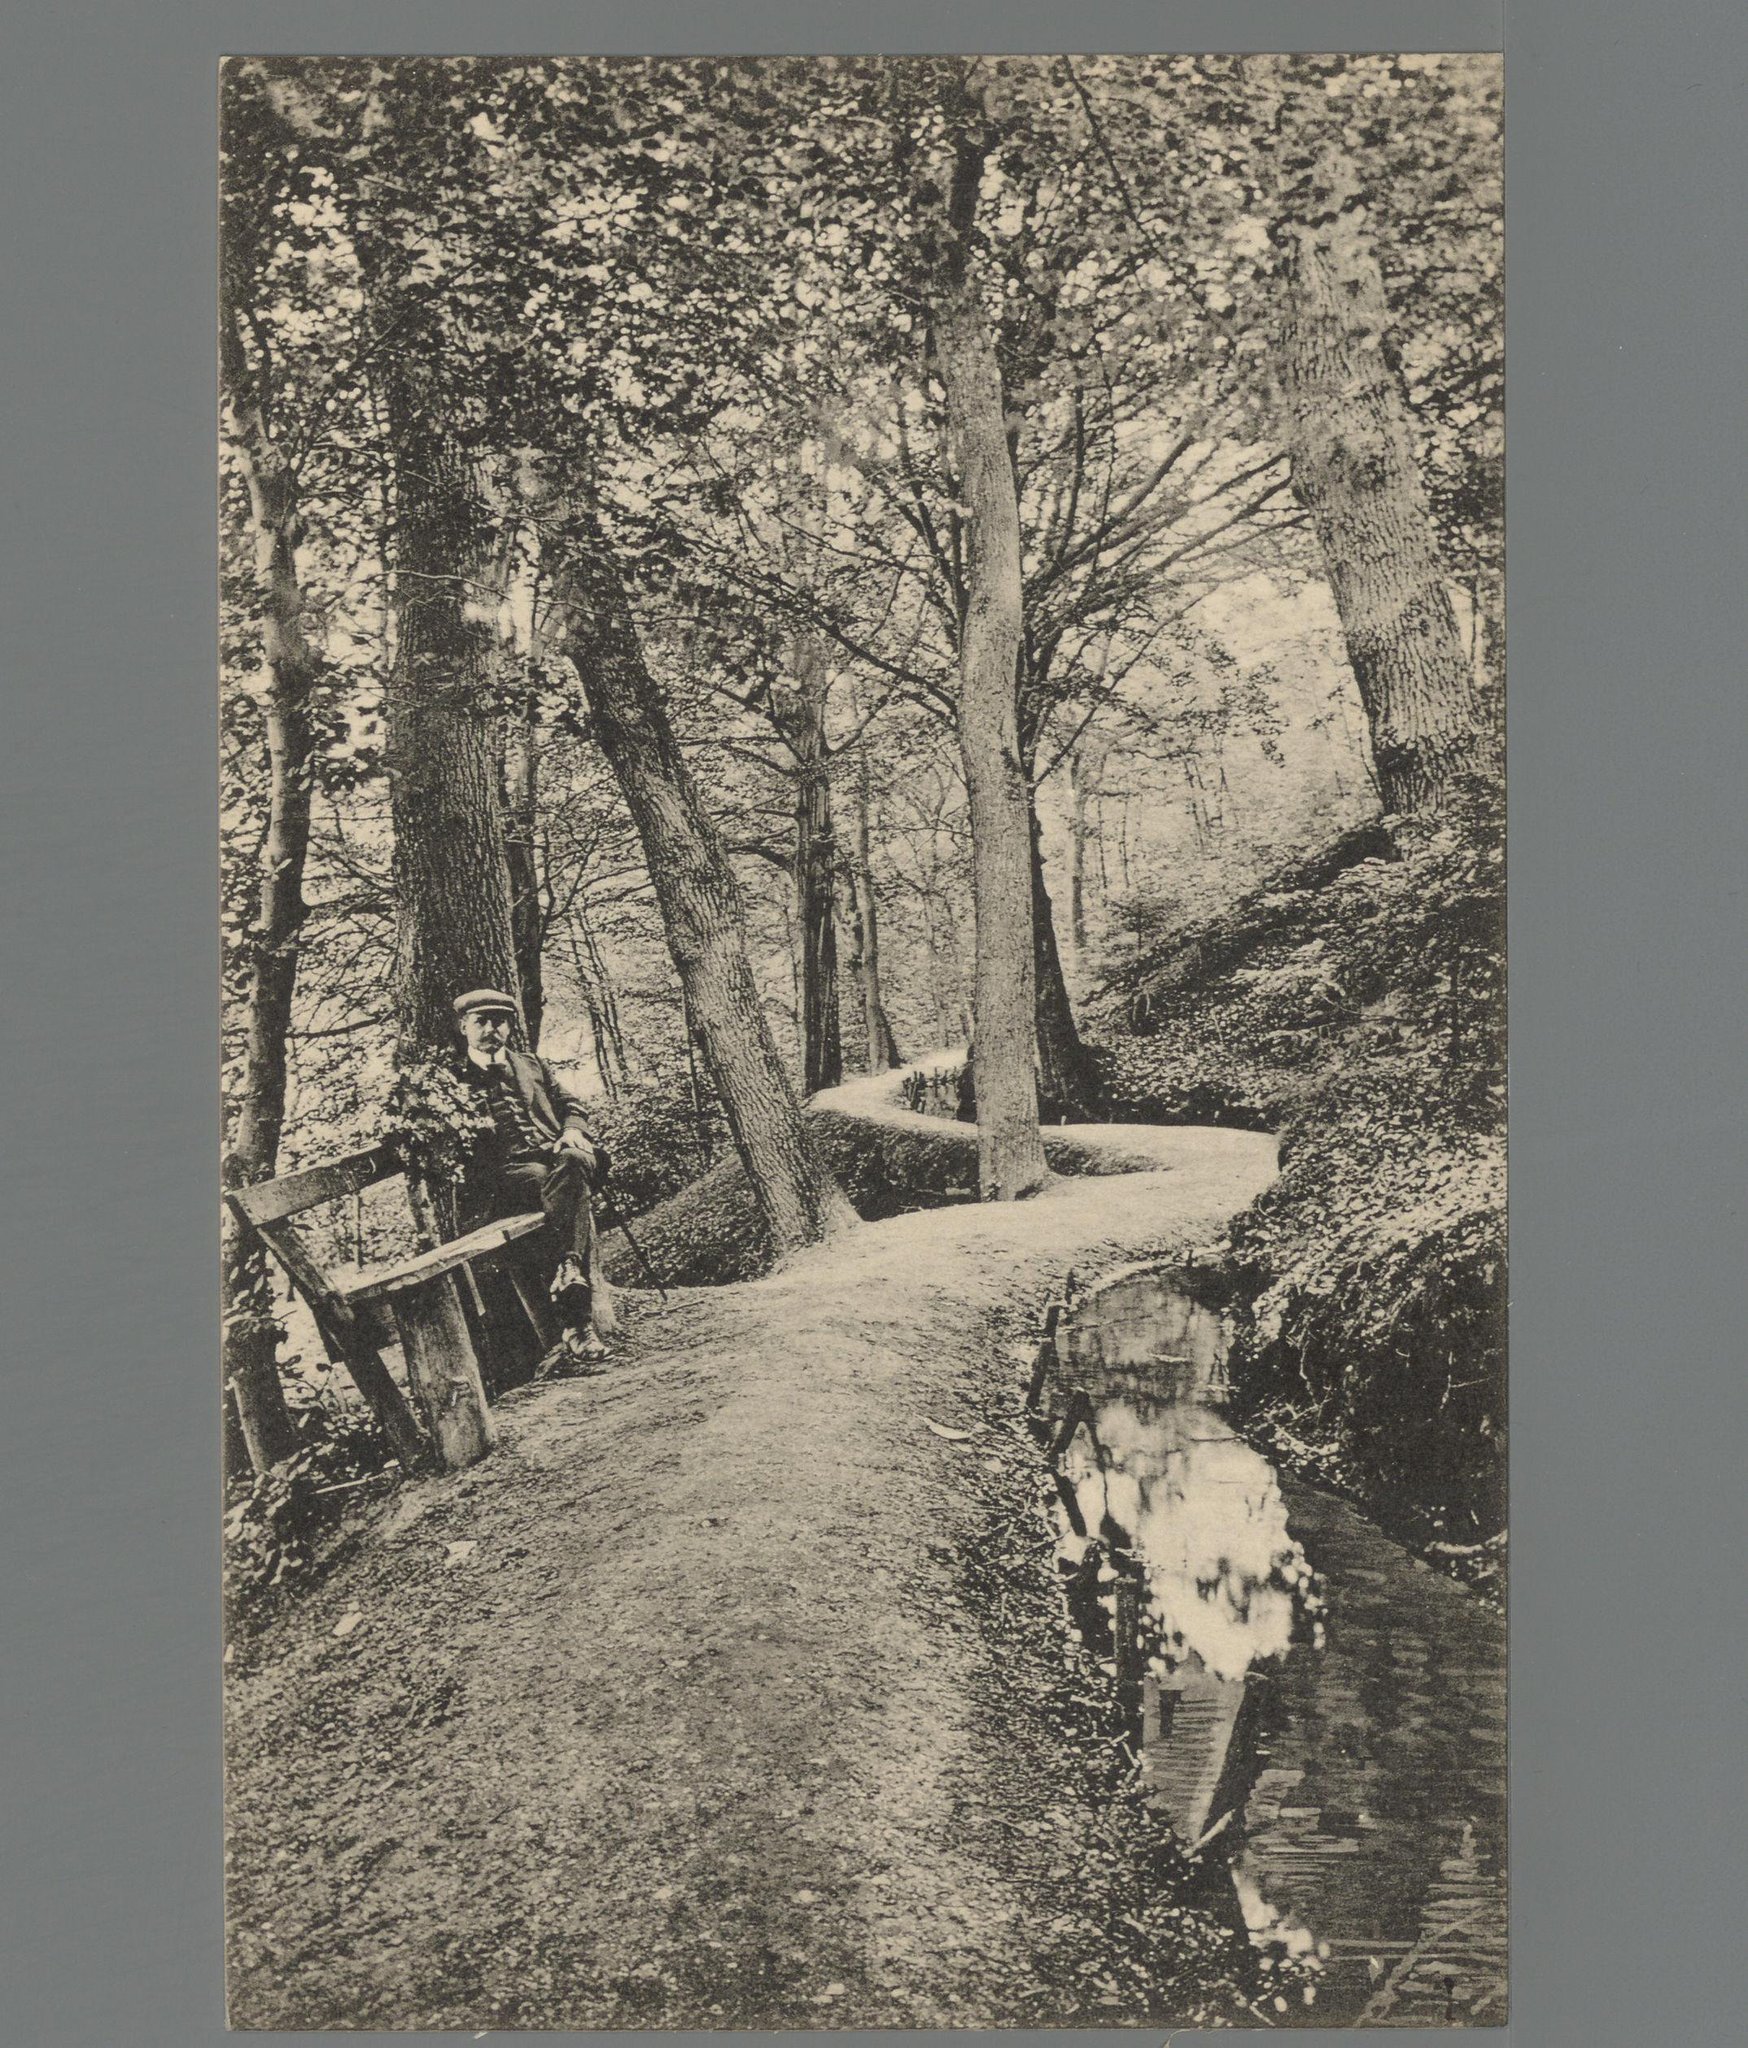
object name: photomechanical print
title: Mook bij Nijmegen. Plasmolen-Beekweg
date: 1910-1930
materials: cardboard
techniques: photograph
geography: mook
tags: forest path or lane